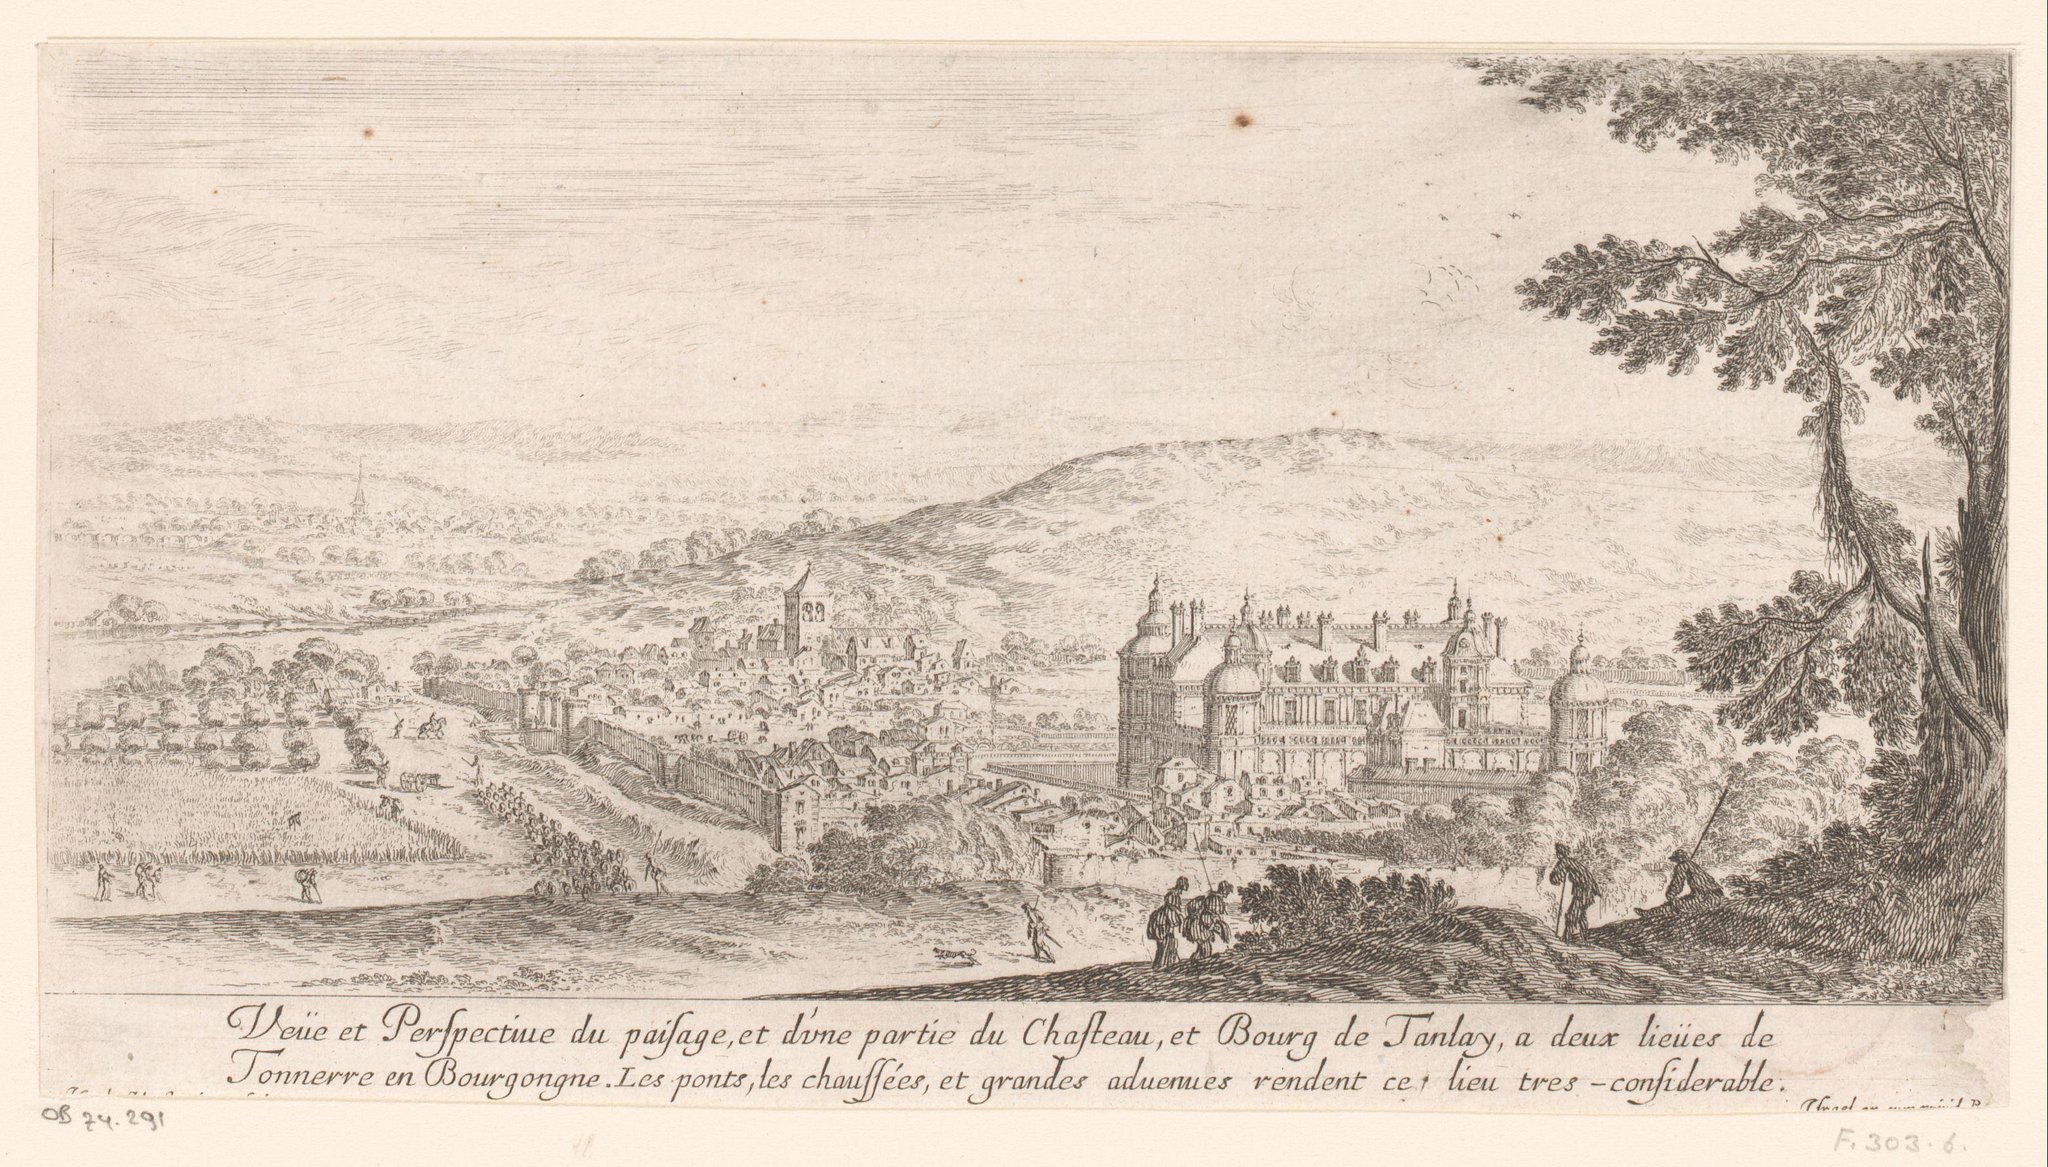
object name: print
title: Veue et Perspective du paisage et d'une partie du Chasteau et Bourg de Tanlay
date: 1631-1661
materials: paper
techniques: etching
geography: france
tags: city-view, and landscape with man-made constructions (+ city(-scape) with figures, staffage)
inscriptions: collector's mark: Lugt 240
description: Prent maakt deel uit van een ongenummerde serie van zes prenten.